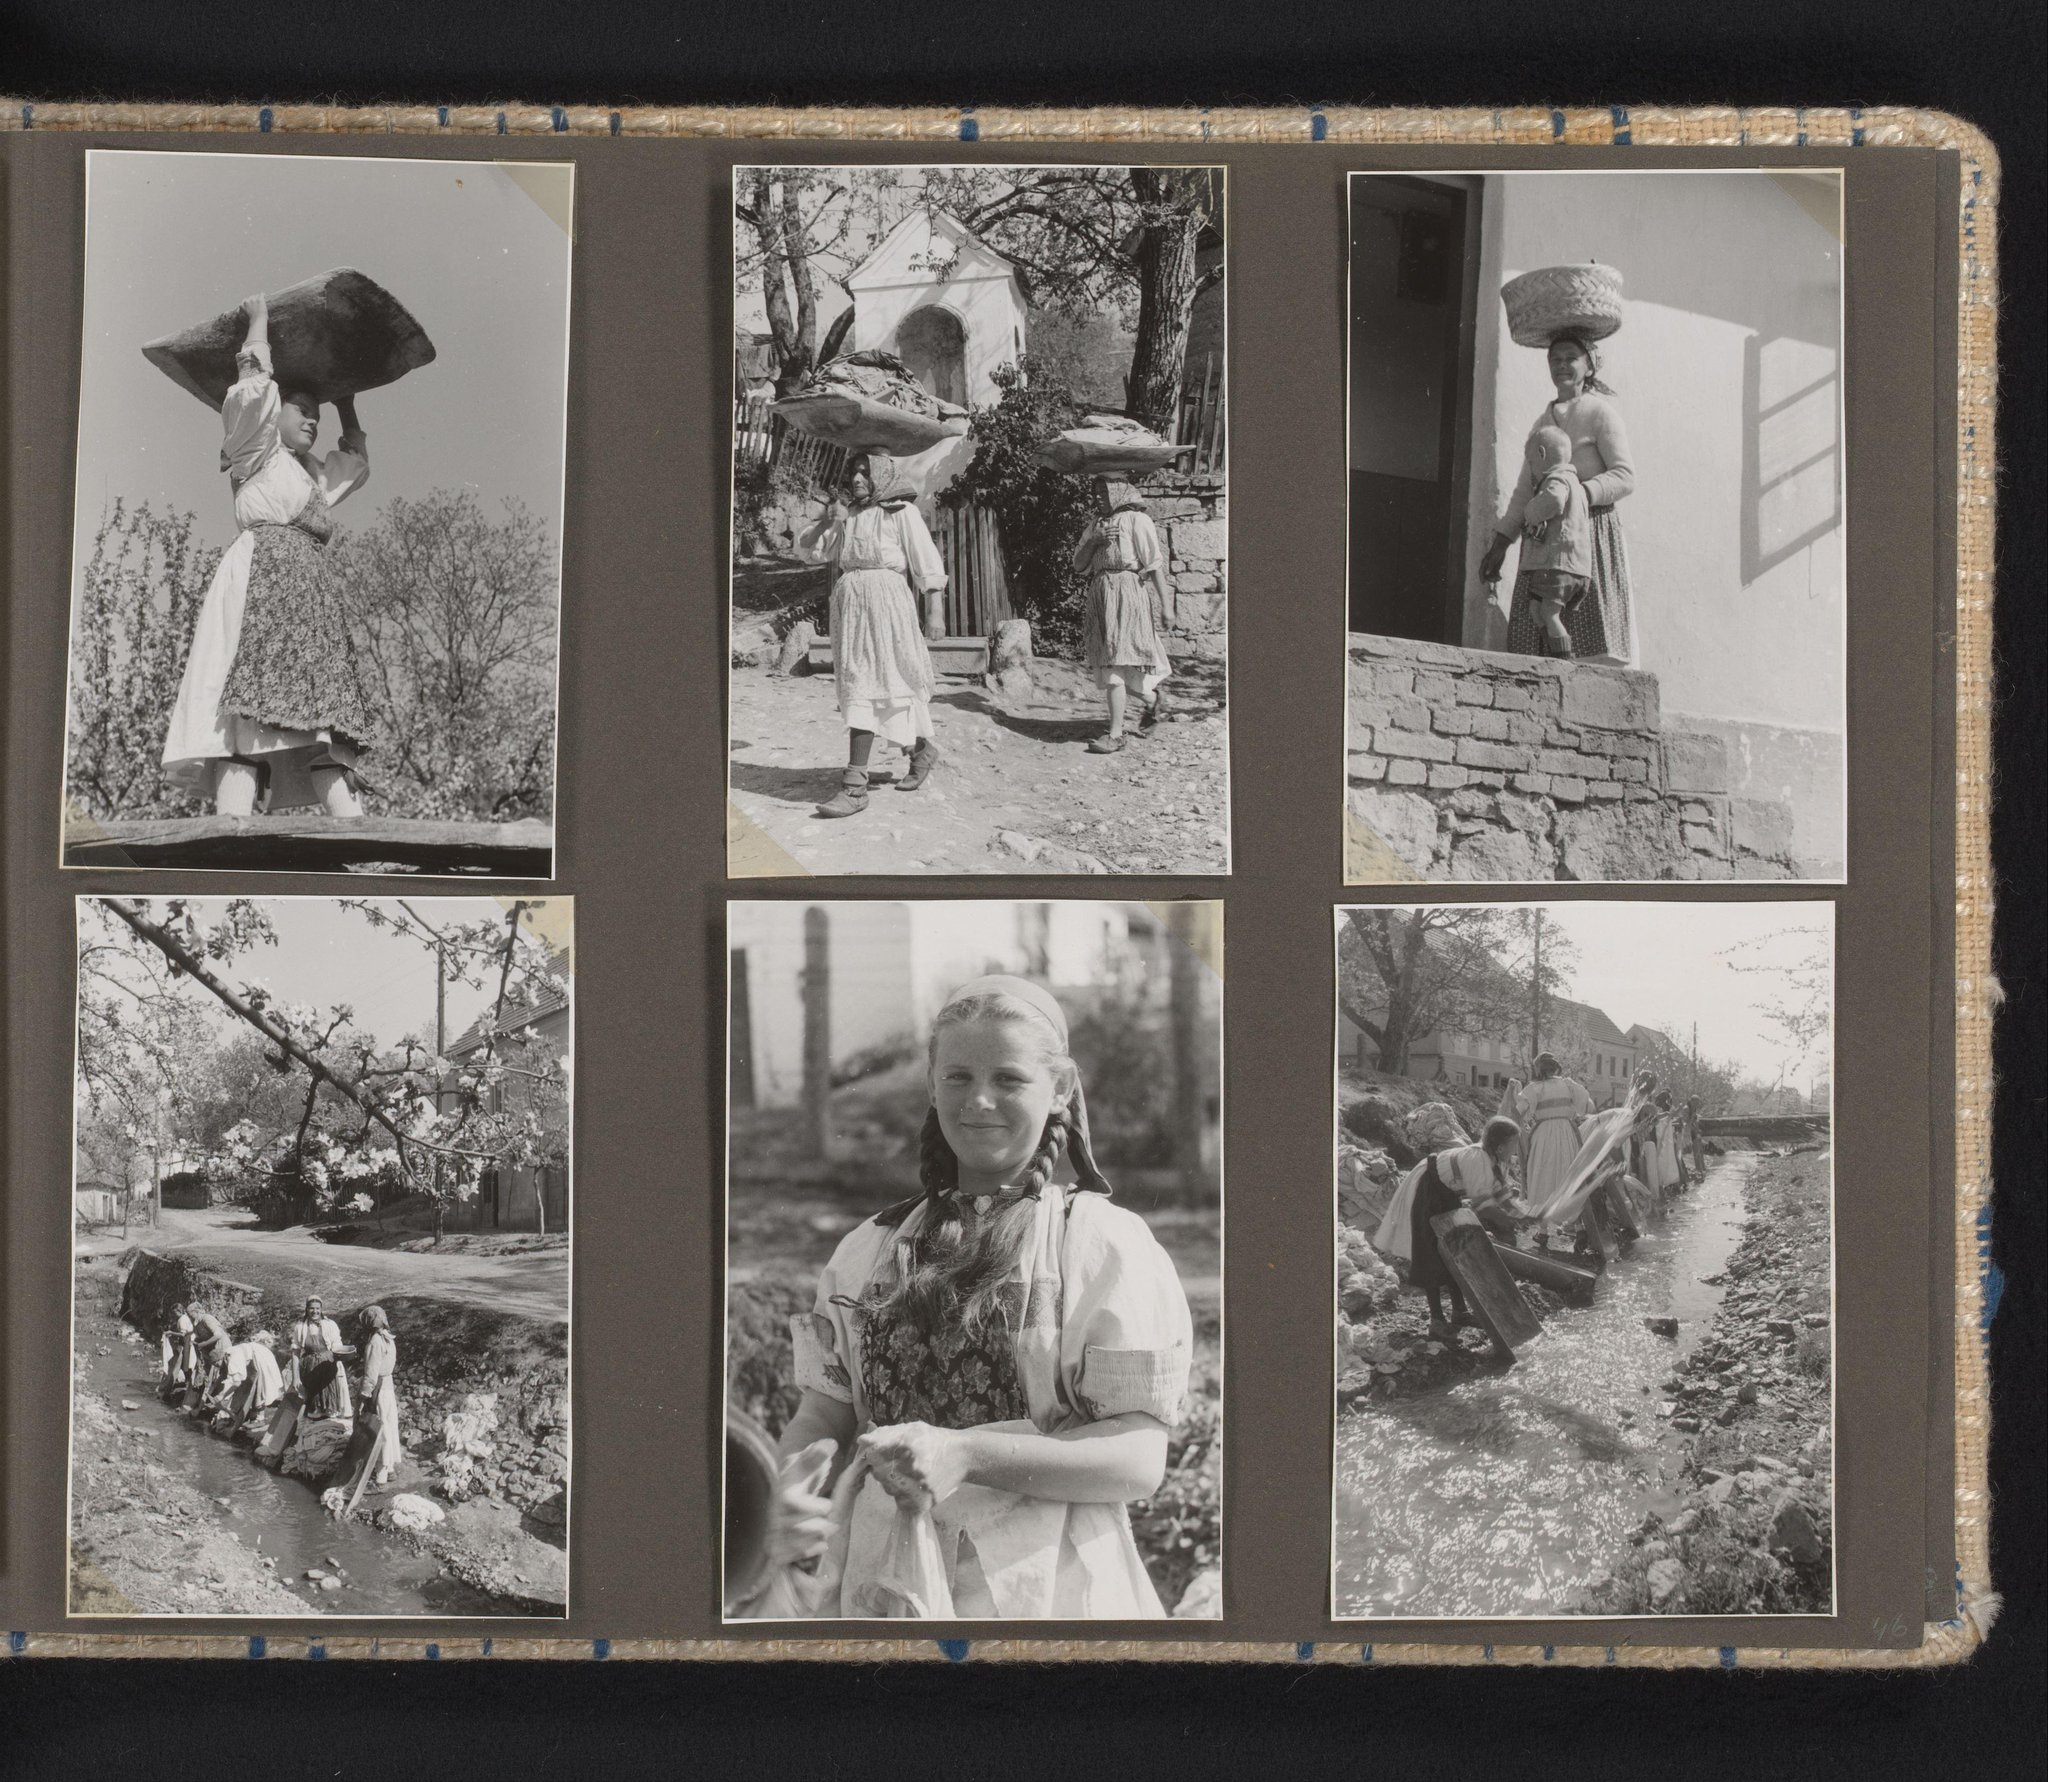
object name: photograph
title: Joegoslavië, april 1943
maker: Anonymous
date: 1904-1943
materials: cardboard, photographic support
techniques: gelatin silver print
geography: yugoslavia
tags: laundering, folk costume, regional costume, occupation ~ war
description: Albumblad met zes foto's in Joegoslavië, waarschijnlijk april 1943: vrouwen in lokale dracht die de was doen in een rivier. Onderdeel van het fotoalbum Abrechnungsintendantur van de Wehrmacht 1941-1943.